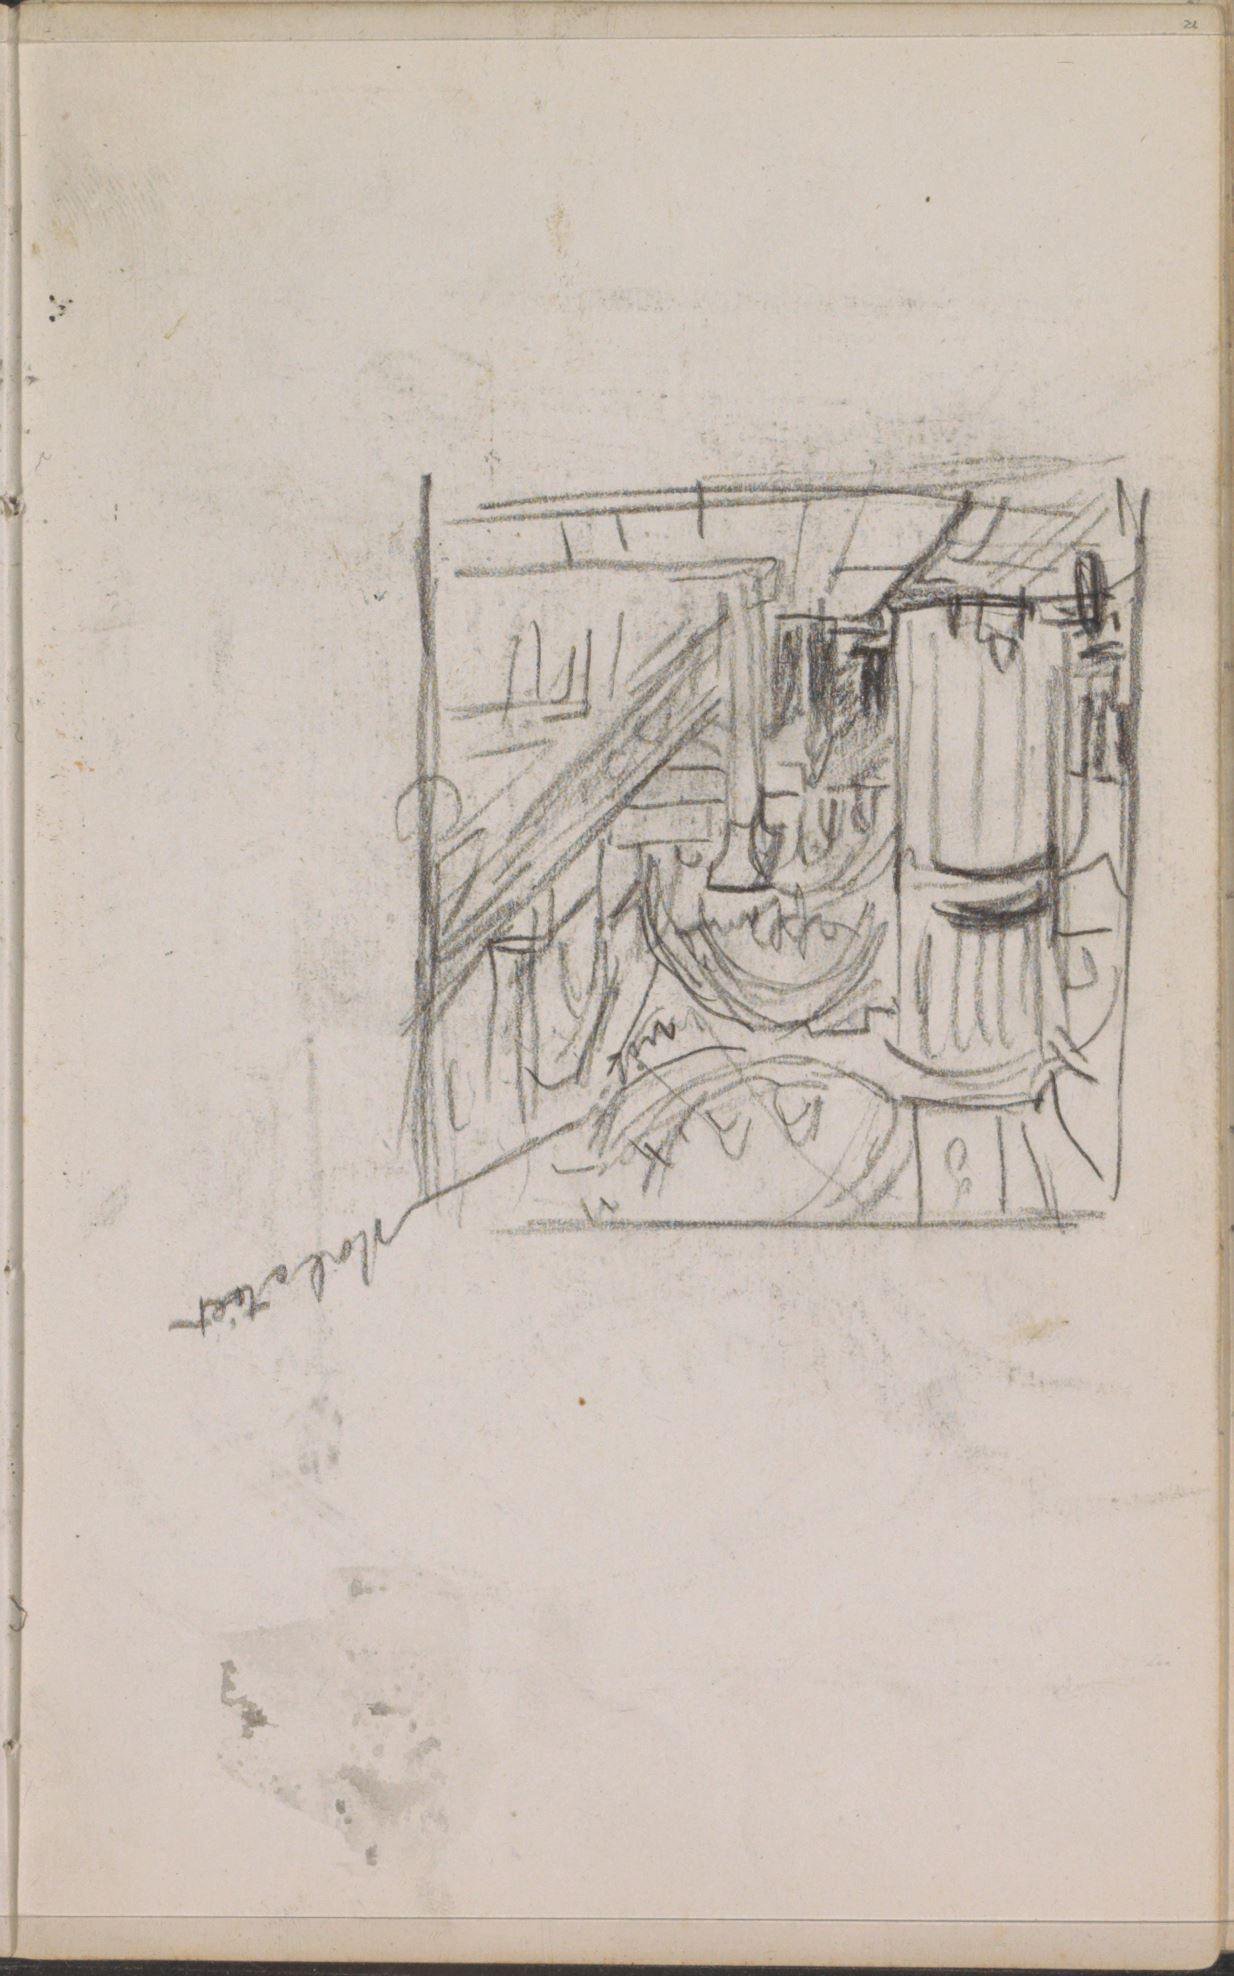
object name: sketchbook leaf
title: Interieur van een moskee met een preekstoel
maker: marius bauer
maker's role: draughtsman, print maker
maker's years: 1867-1932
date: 1896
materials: chalk, paper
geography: istanbul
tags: temple, shrine ~ islam, mohammedanism, dome ~ architecture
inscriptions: kleurnotitie, handgeschreven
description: Pagina 21 uit een schetsboek met 53 bladen.